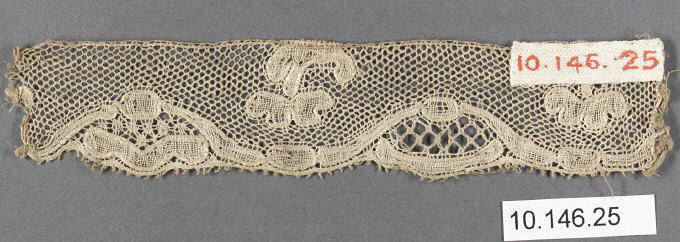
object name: fragment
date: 1701-1800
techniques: lace